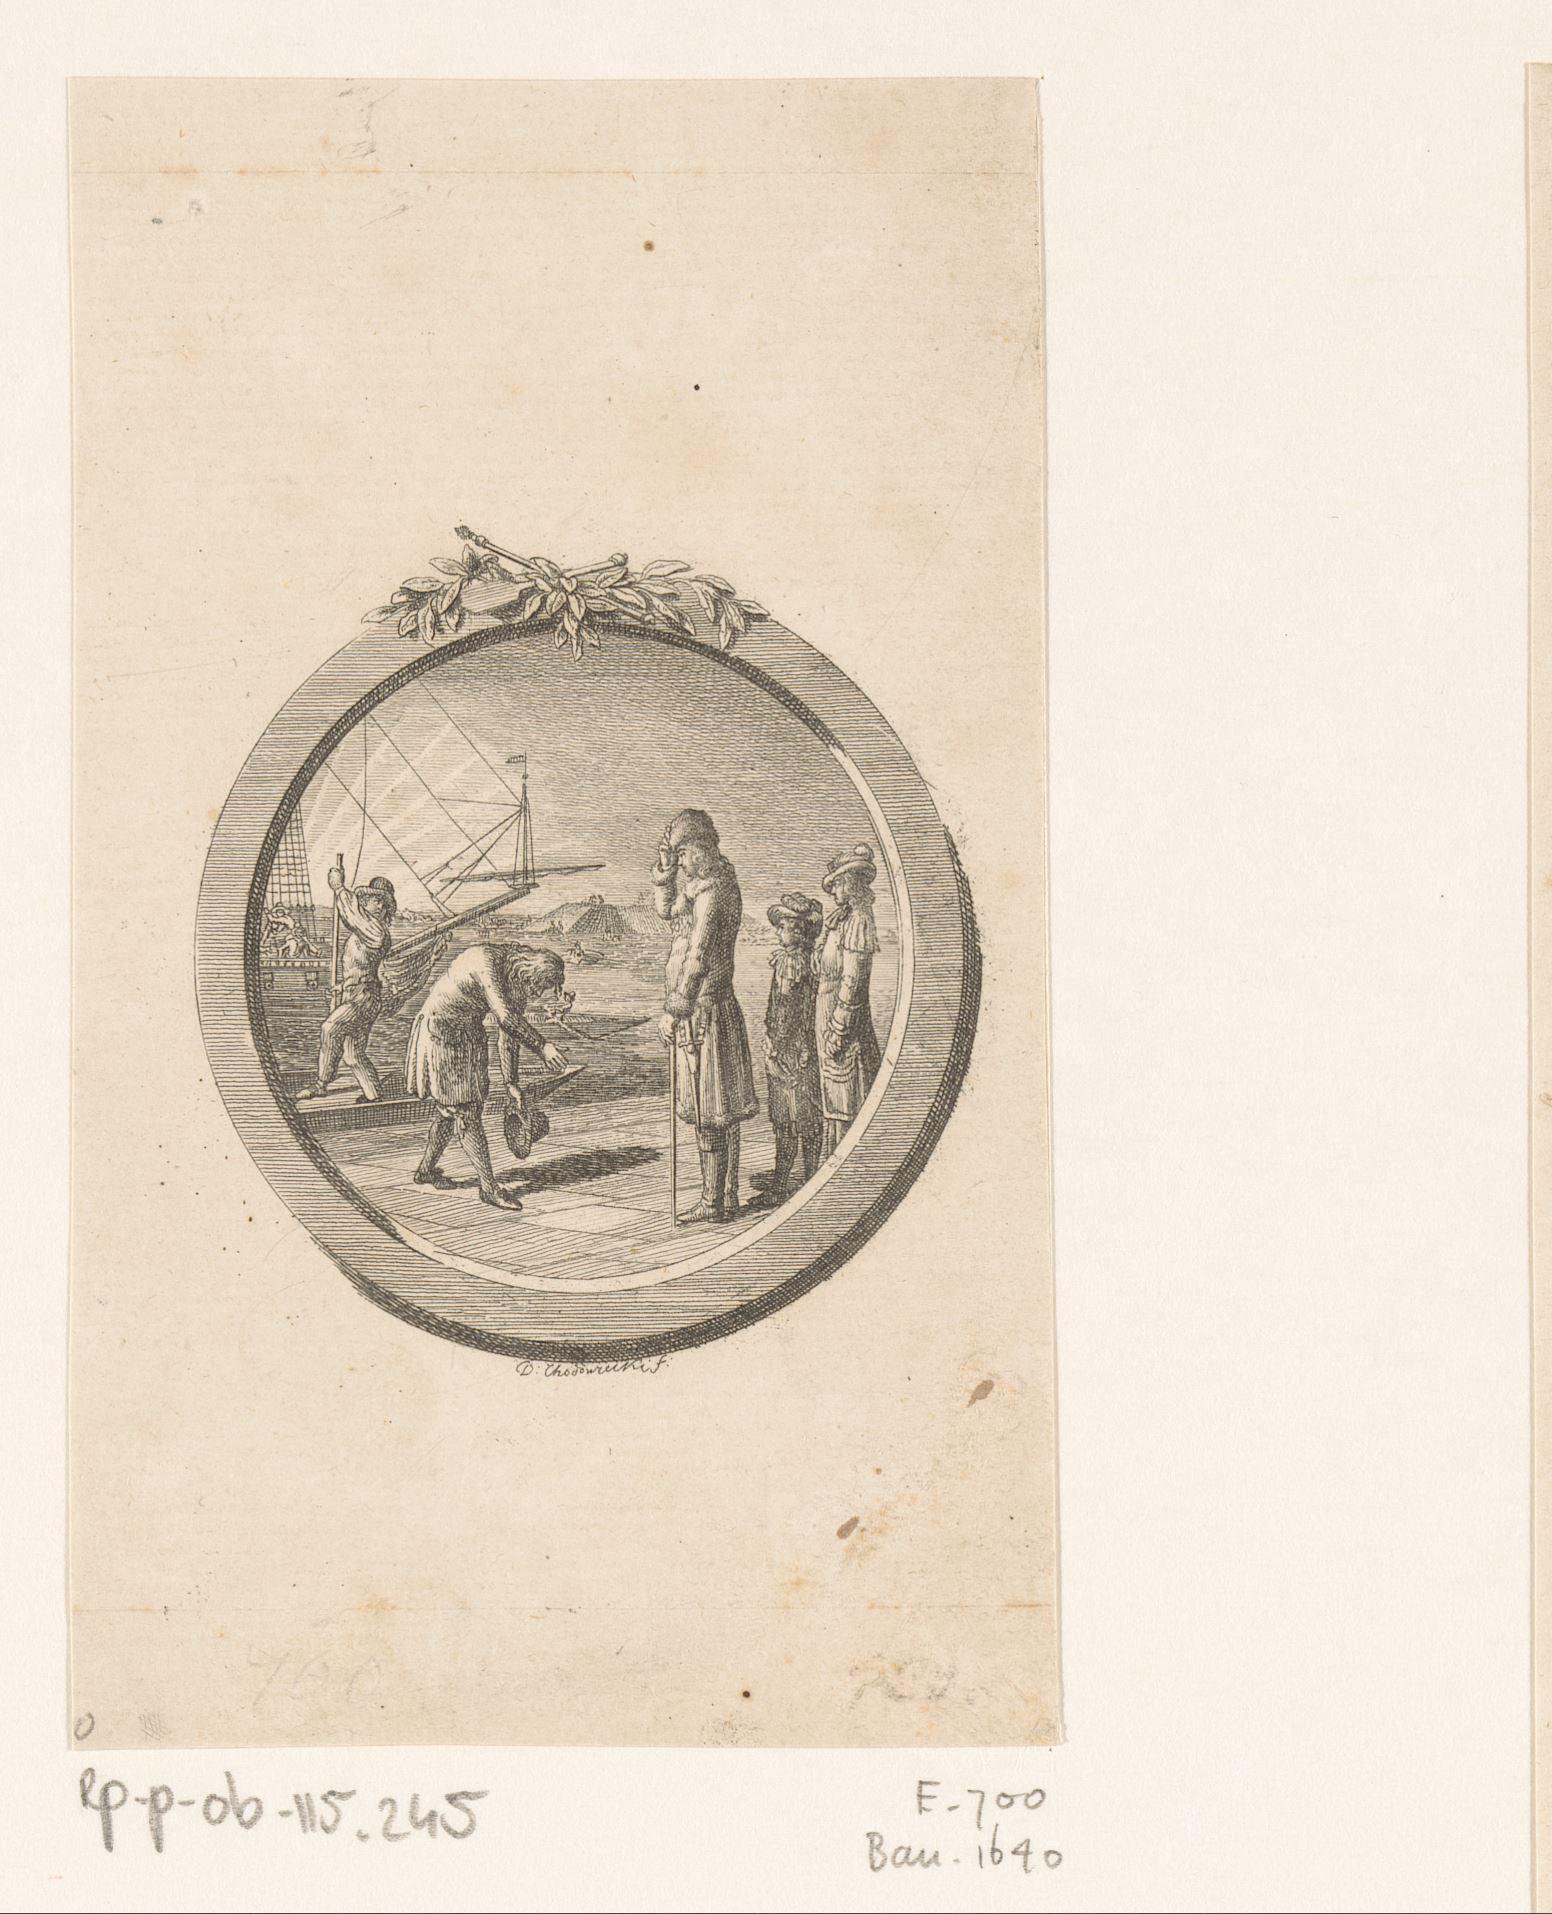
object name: print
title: Hollandse schipper buigt voor Karel de Grote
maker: daniel nikolaus chodowiecki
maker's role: draughtsman, print maker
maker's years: 1726-1801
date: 1793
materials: paper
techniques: etching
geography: berlin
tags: peter i de grote (tsaar van rusland), ornament ~ medallion, ships (in general), harbouring, making a bow to a ruler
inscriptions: collector's mark: Lugt 2228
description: Prent gebruikt voor: Storch, Heinrich. Gemählde von St. Petersburg. 2 dln. Riga: Johann Friedrich Hartknoch, 1794, dl. 1.